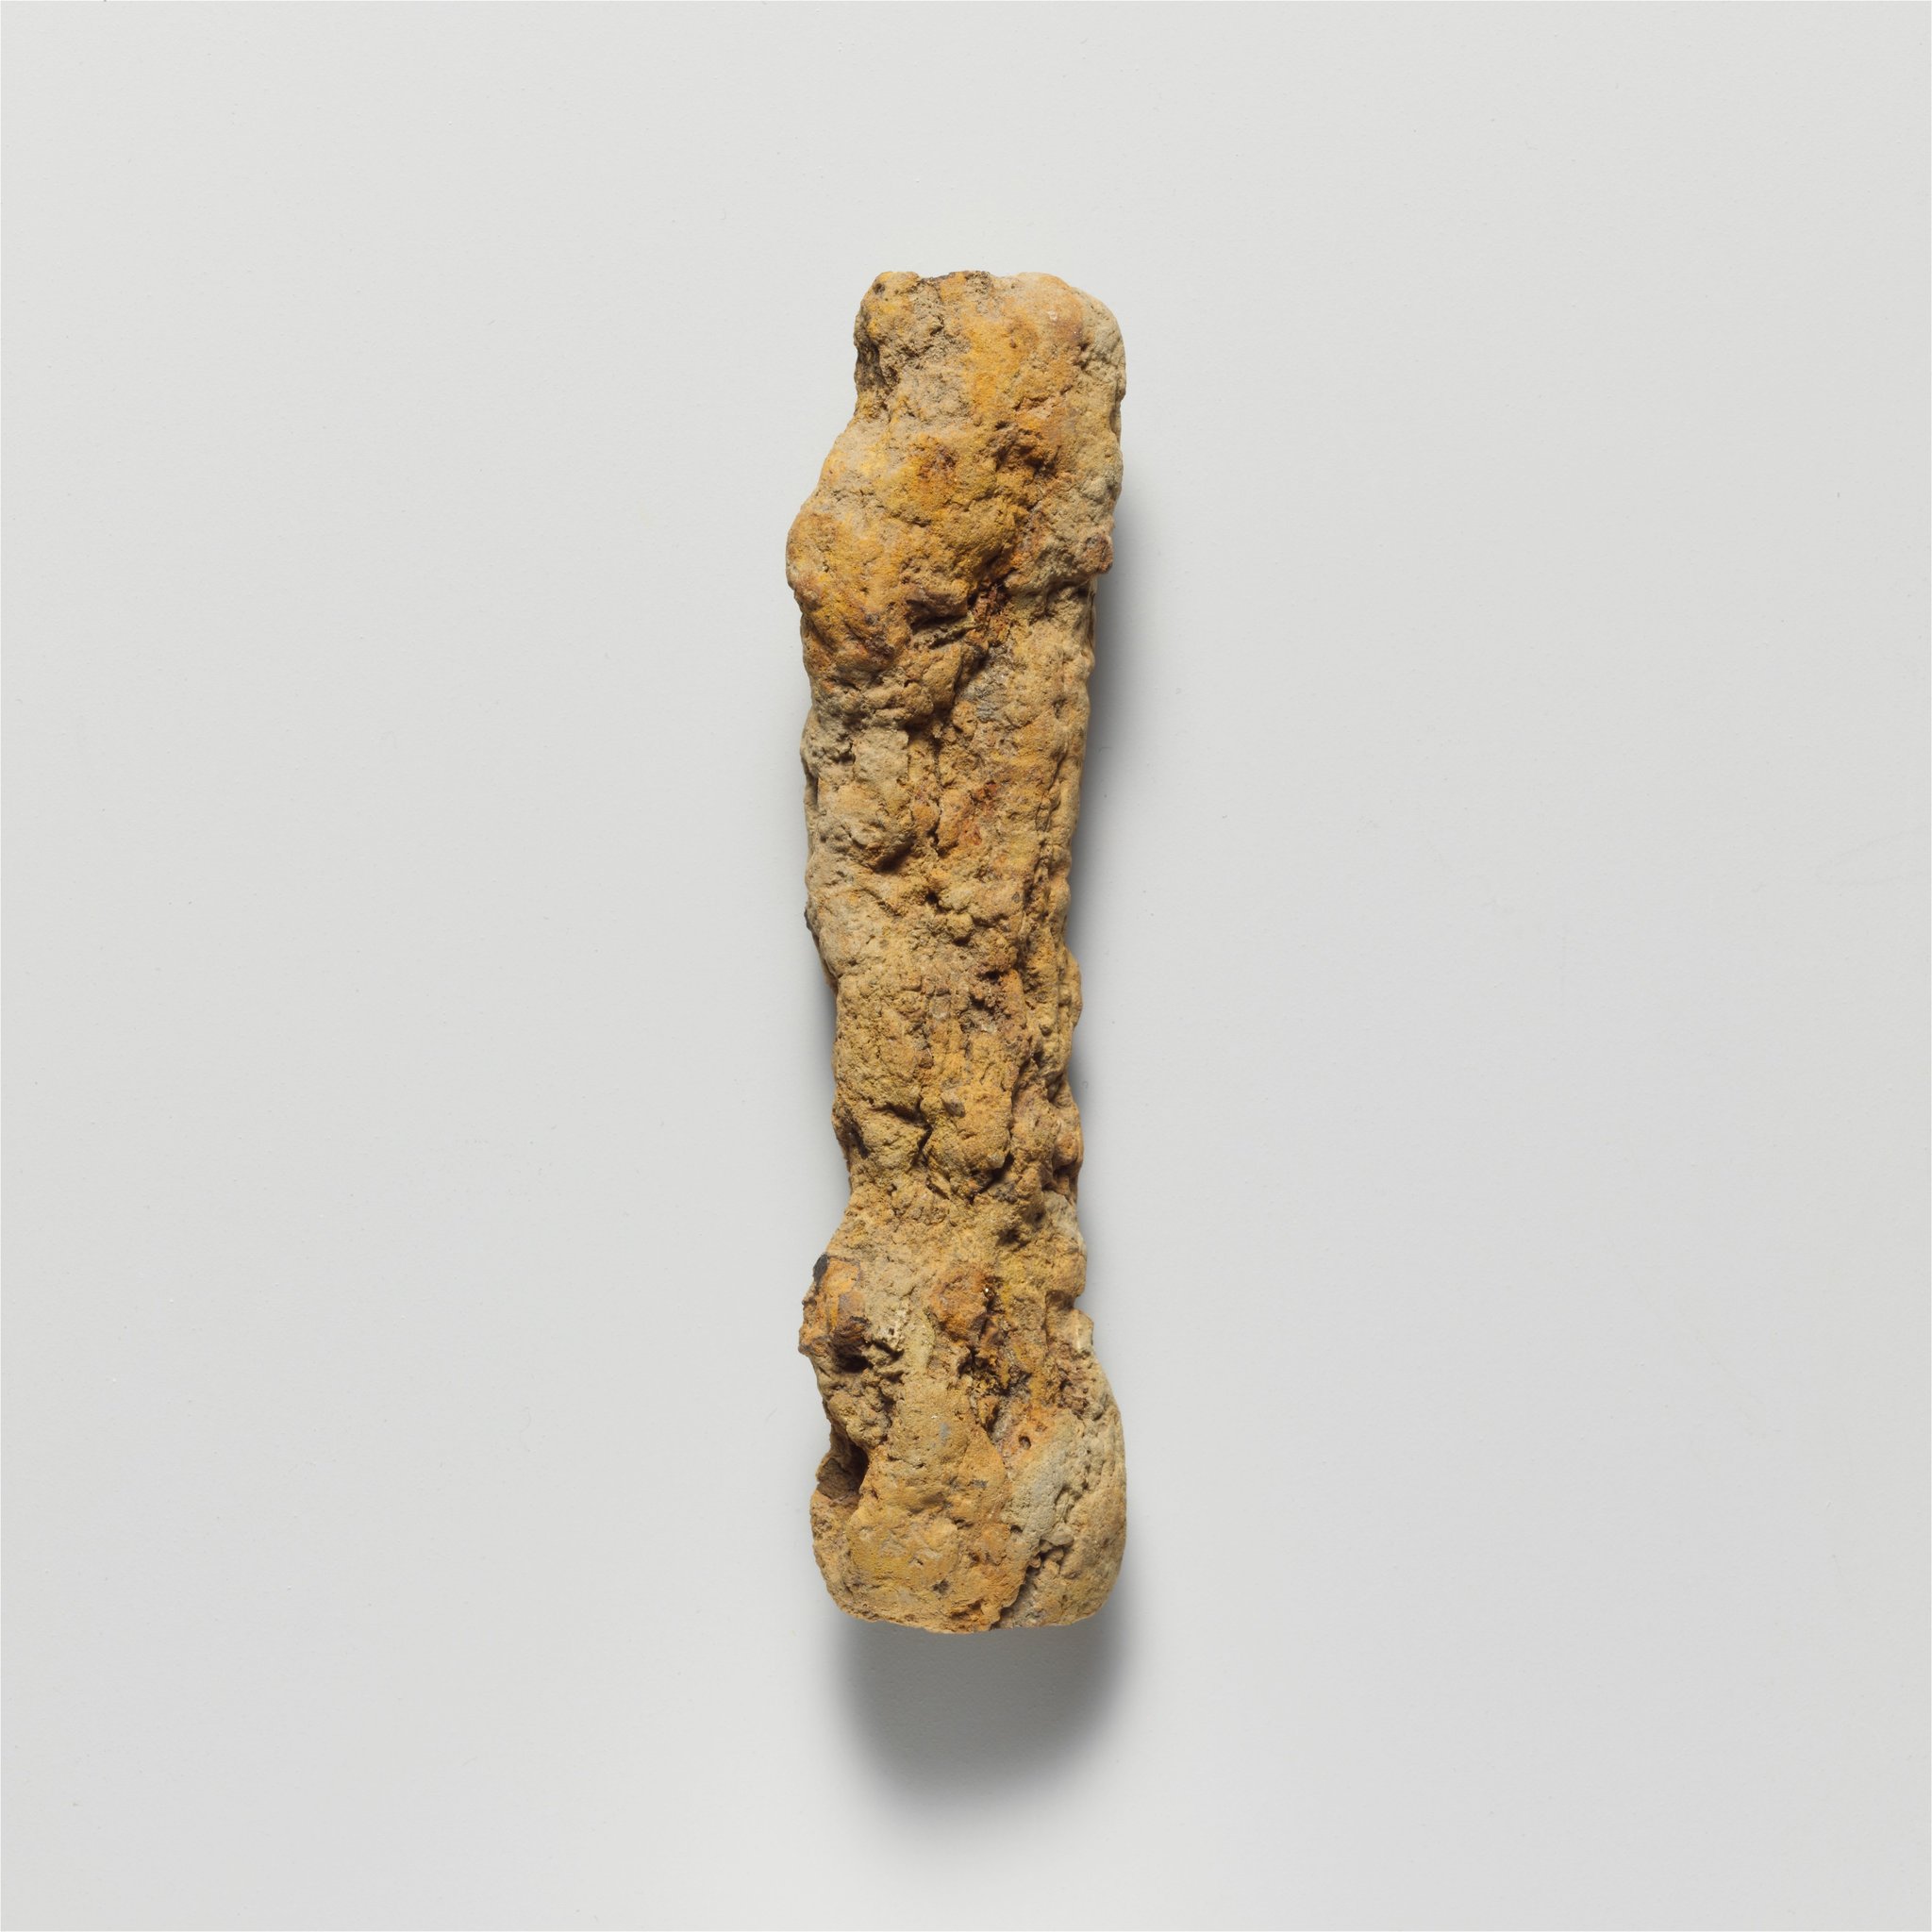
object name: bar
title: Iron bar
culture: greek, laconian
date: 700-401 BCE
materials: iron